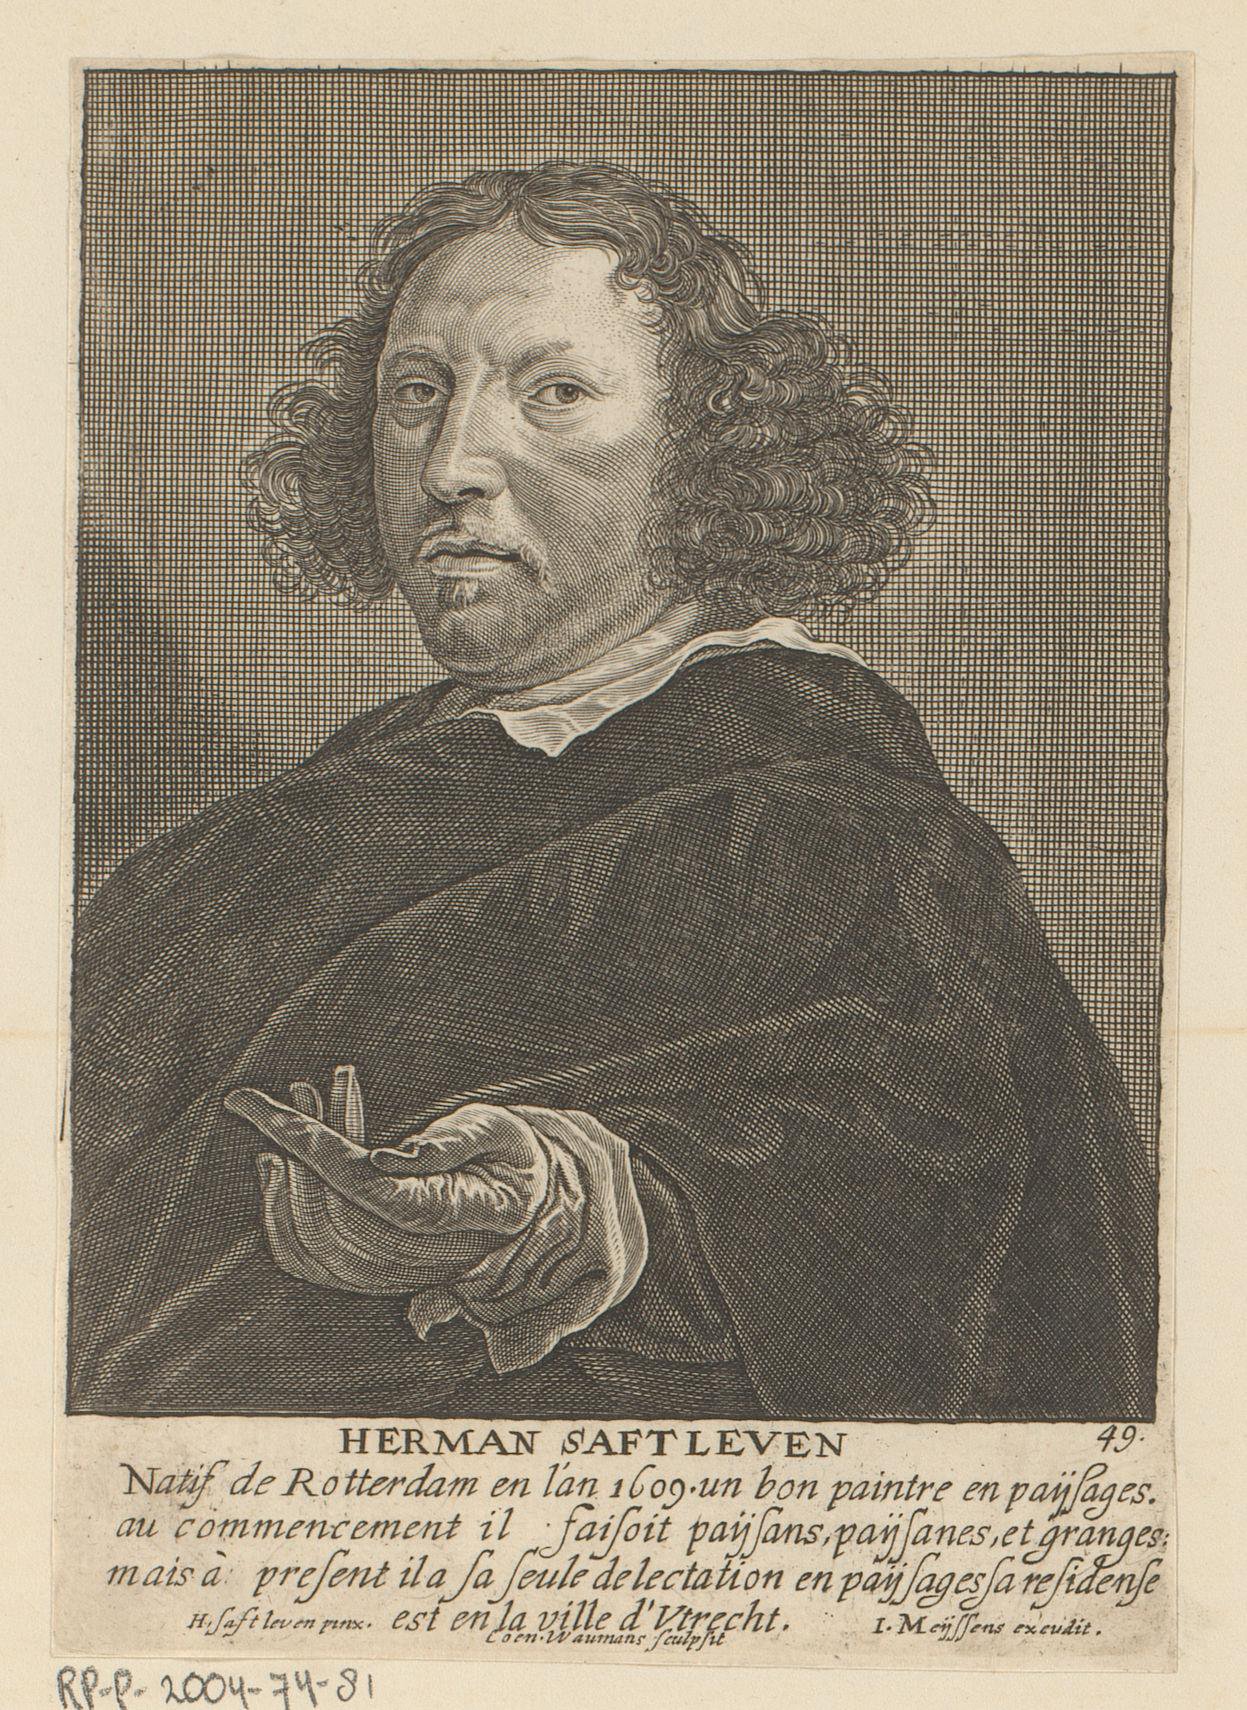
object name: album leaf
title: Portret van Herman Saftleven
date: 1649-1662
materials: paper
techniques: engraving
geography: antwerp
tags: rotterdam, utrecht, painter, draughtsman, herman saftleven, historical persons, portrait, self-portrait of painter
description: Prent mogelijk uit: Meyssens, Joannes. Image de divers hommes desprit sublime qui par leur art et science deburovent vivre eternellement et des quels la louange et renommée faict estonner le monde. 2 dln. Antwerpen: Joannes Meyssens, 1649, dl. 1, p. 59. De samensteller heeft deze prent in het album geplakt als illustratie bij: Pilkington, Matthew en Johann Heinrich Füssli. A dictionary of painters, from the revival of the art to the present period. 4 dln. Londen: John Crowder, 1805, dl. 3, p. 455.